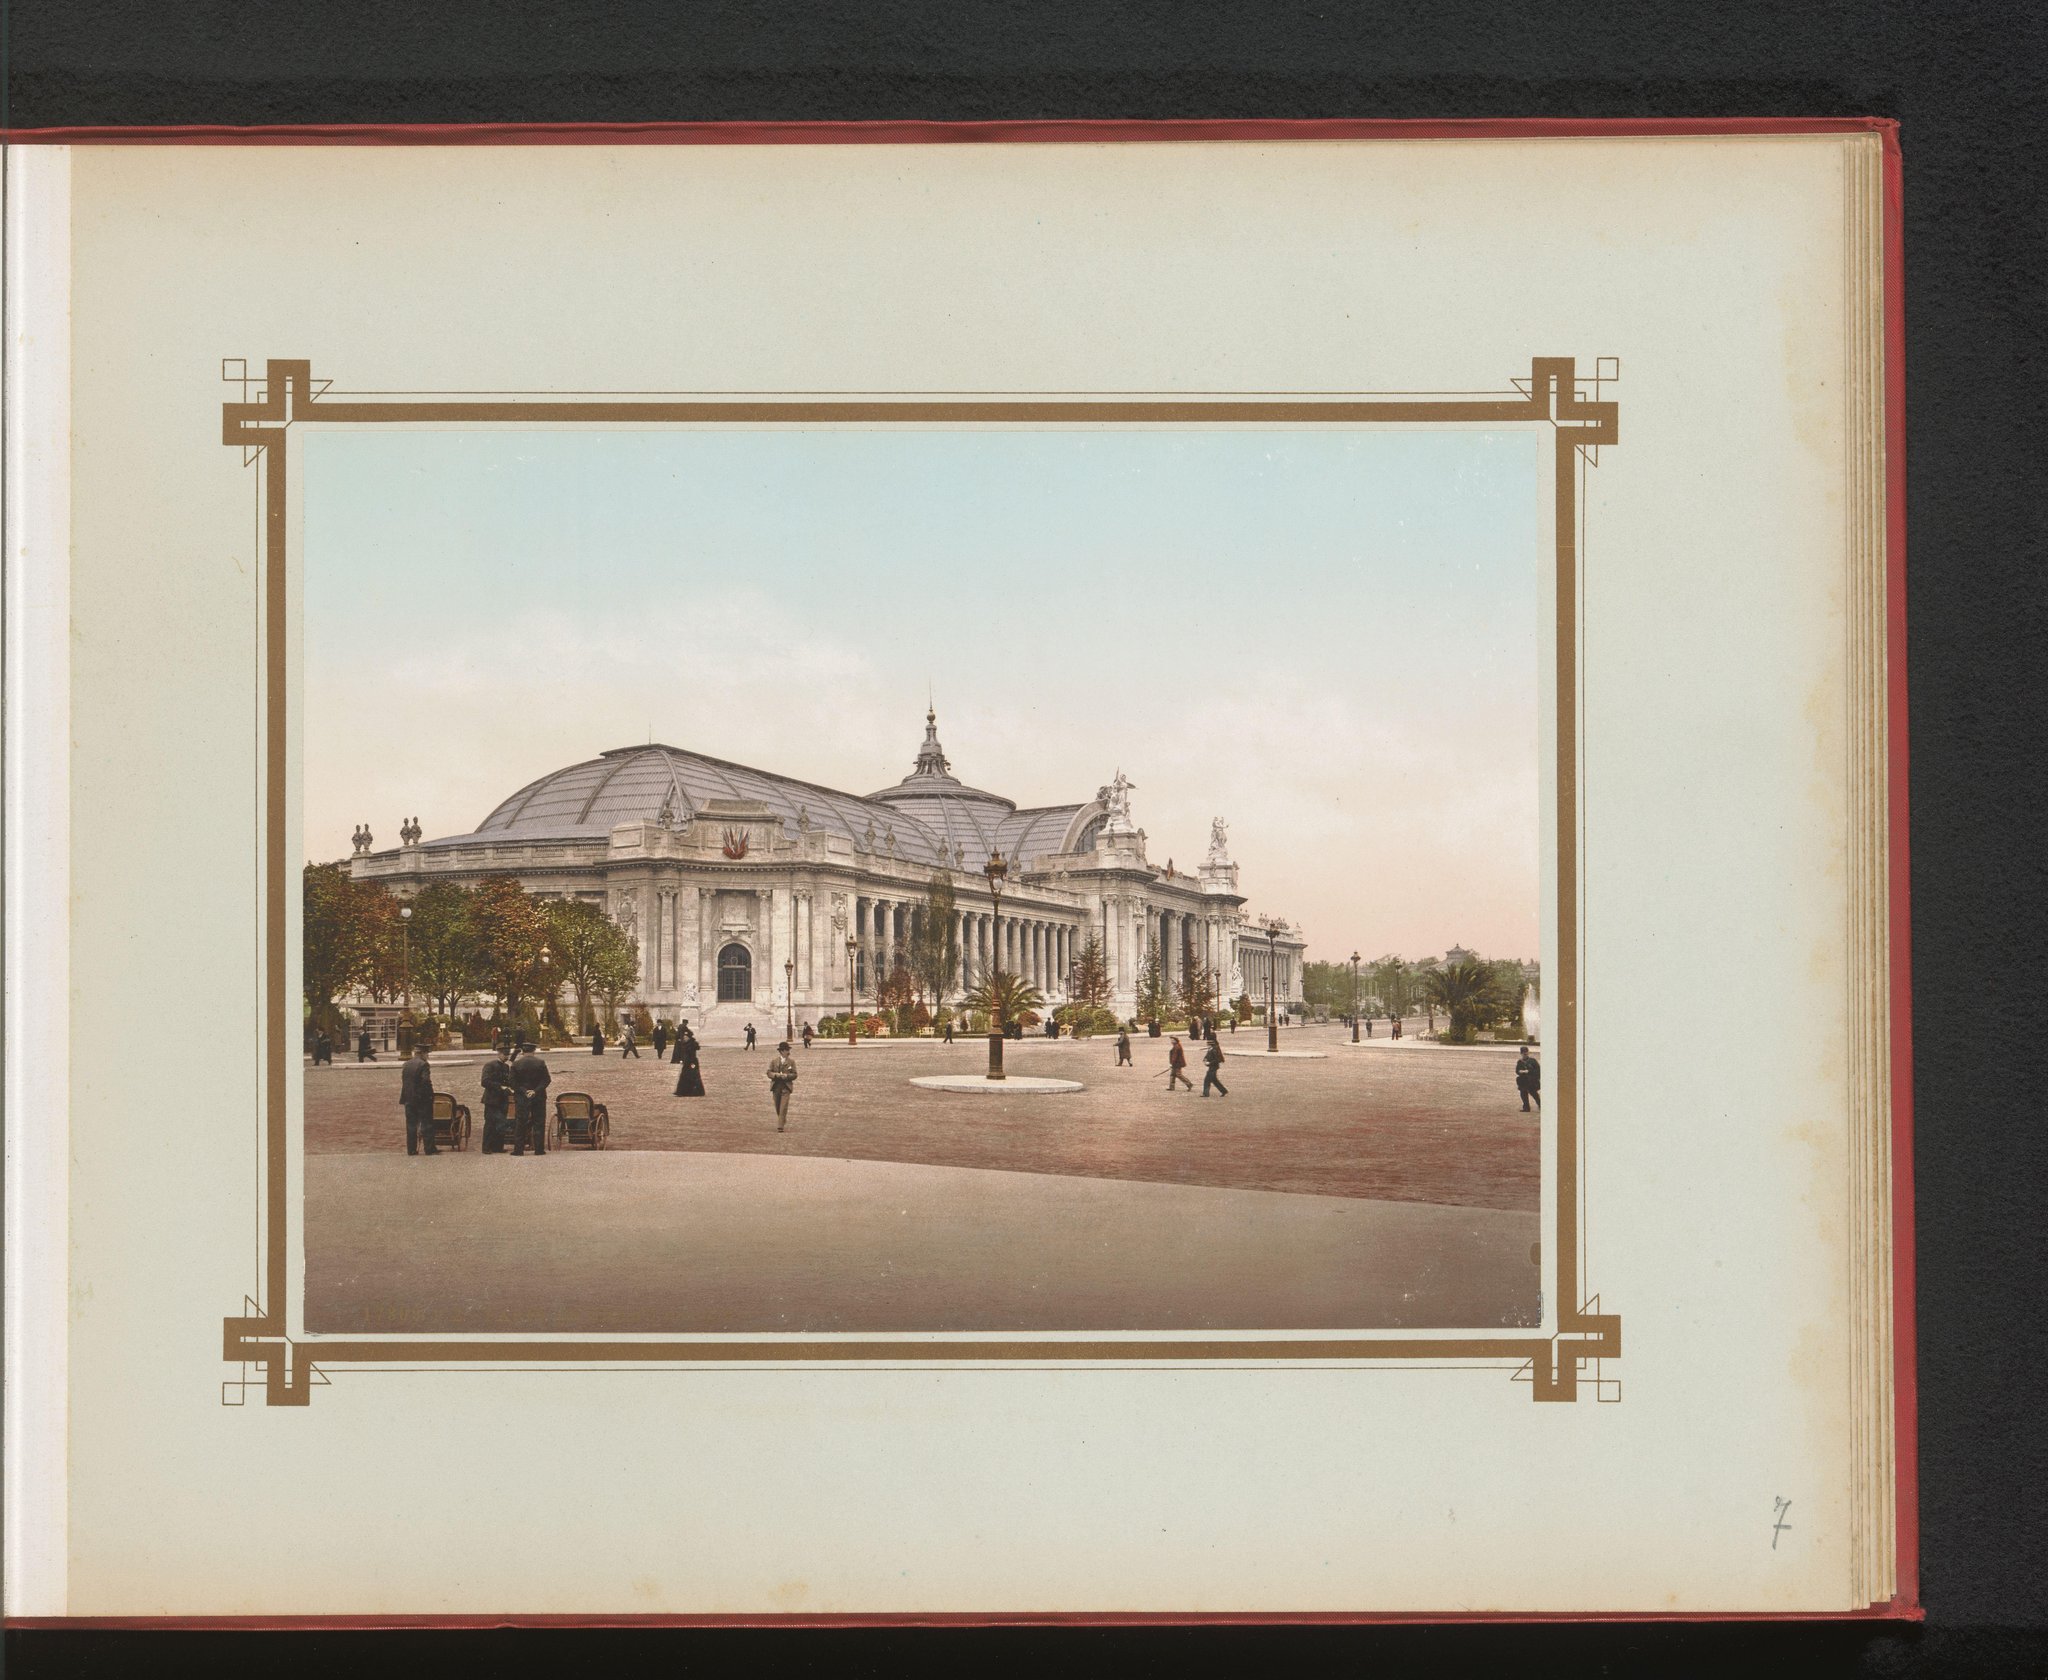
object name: photomechanical print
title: Grand Palais tijdens de Wereldtentoonstelling van 1900 te Parijs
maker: Anonymous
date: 1900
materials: paper, photographic process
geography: paris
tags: world fair, world exhibition, civic architecture; edifices; dwellings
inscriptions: inscription: ‘17309. P.Z.- Paris le Grand Palais’